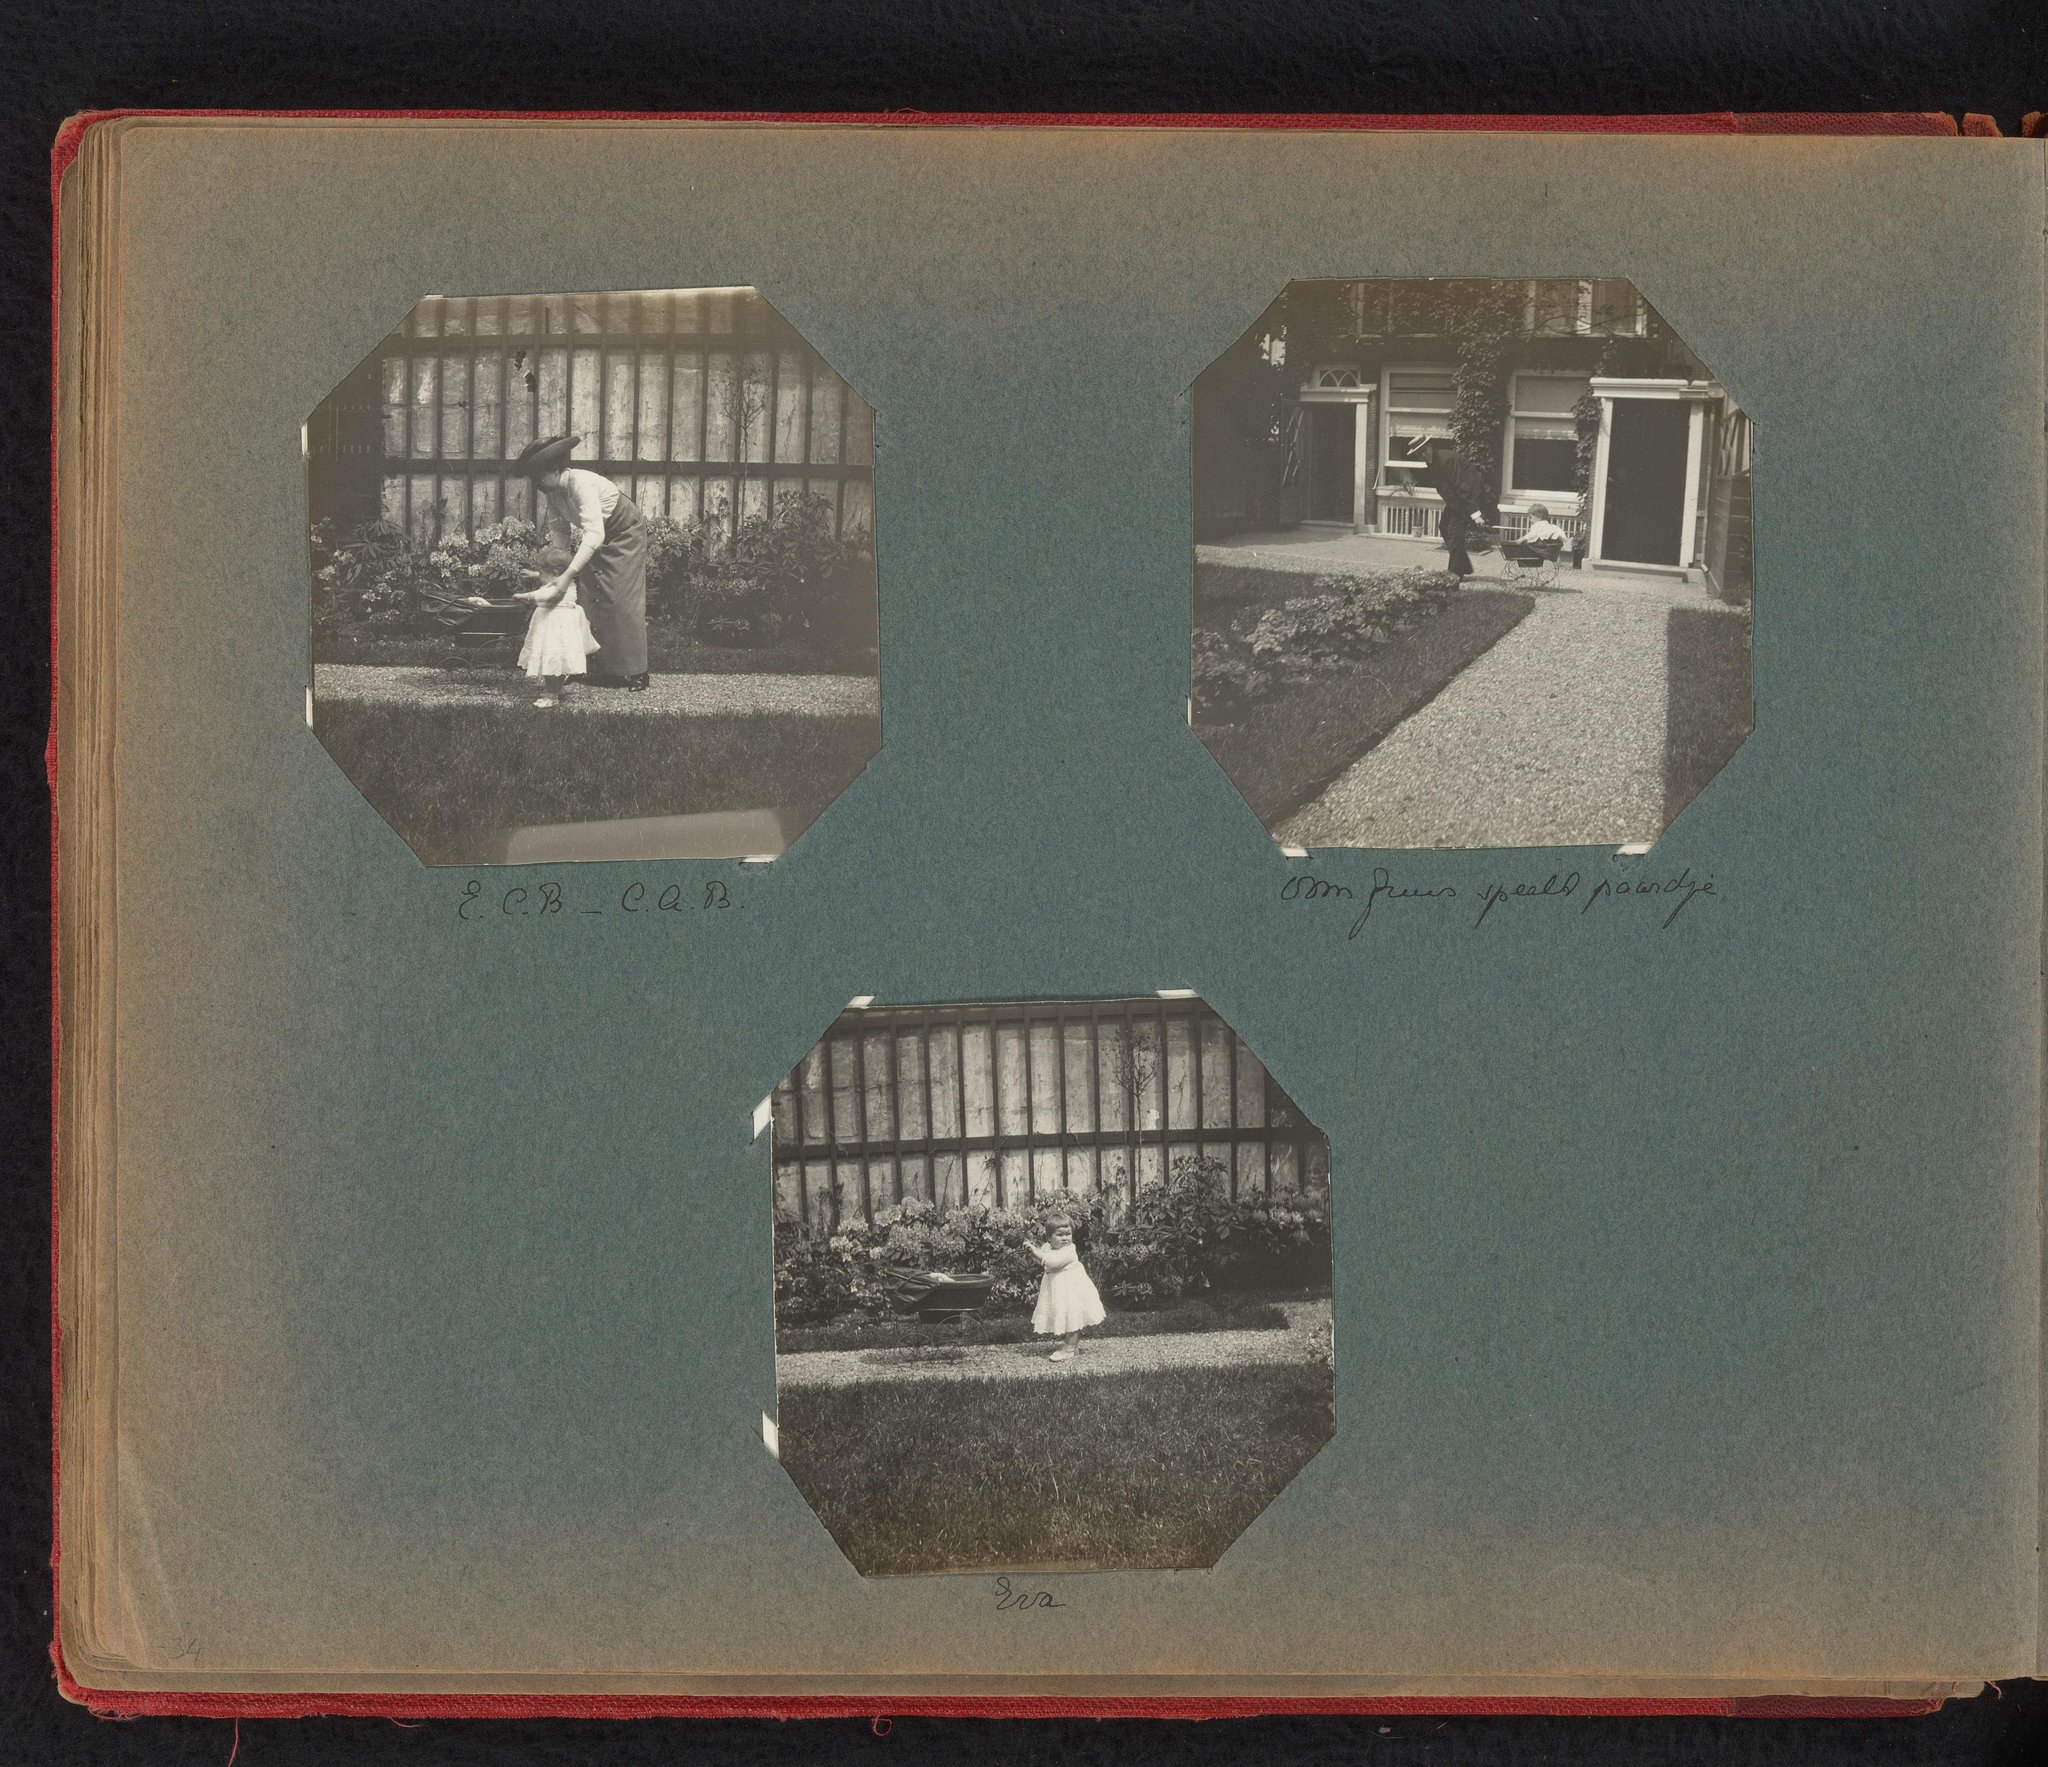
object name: photograph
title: Drie taferelen met Eva Boelen, Charlotte Boelen-Matthes en August Matthes in de tuin van Keizersgracht 756 in Amsterdam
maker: charlotte alida boelen-matthes (lot)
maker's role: amateurfotograaf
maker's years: 1889-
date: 1905-1913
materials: paper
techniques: gelatin silver print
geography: amsterdam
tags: thailand, eva charlotte pennink-boelen, charlotte alida boelen-matthes (lot), garden, toddler (female)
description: Deze foto's zijn onderdeel van een album.